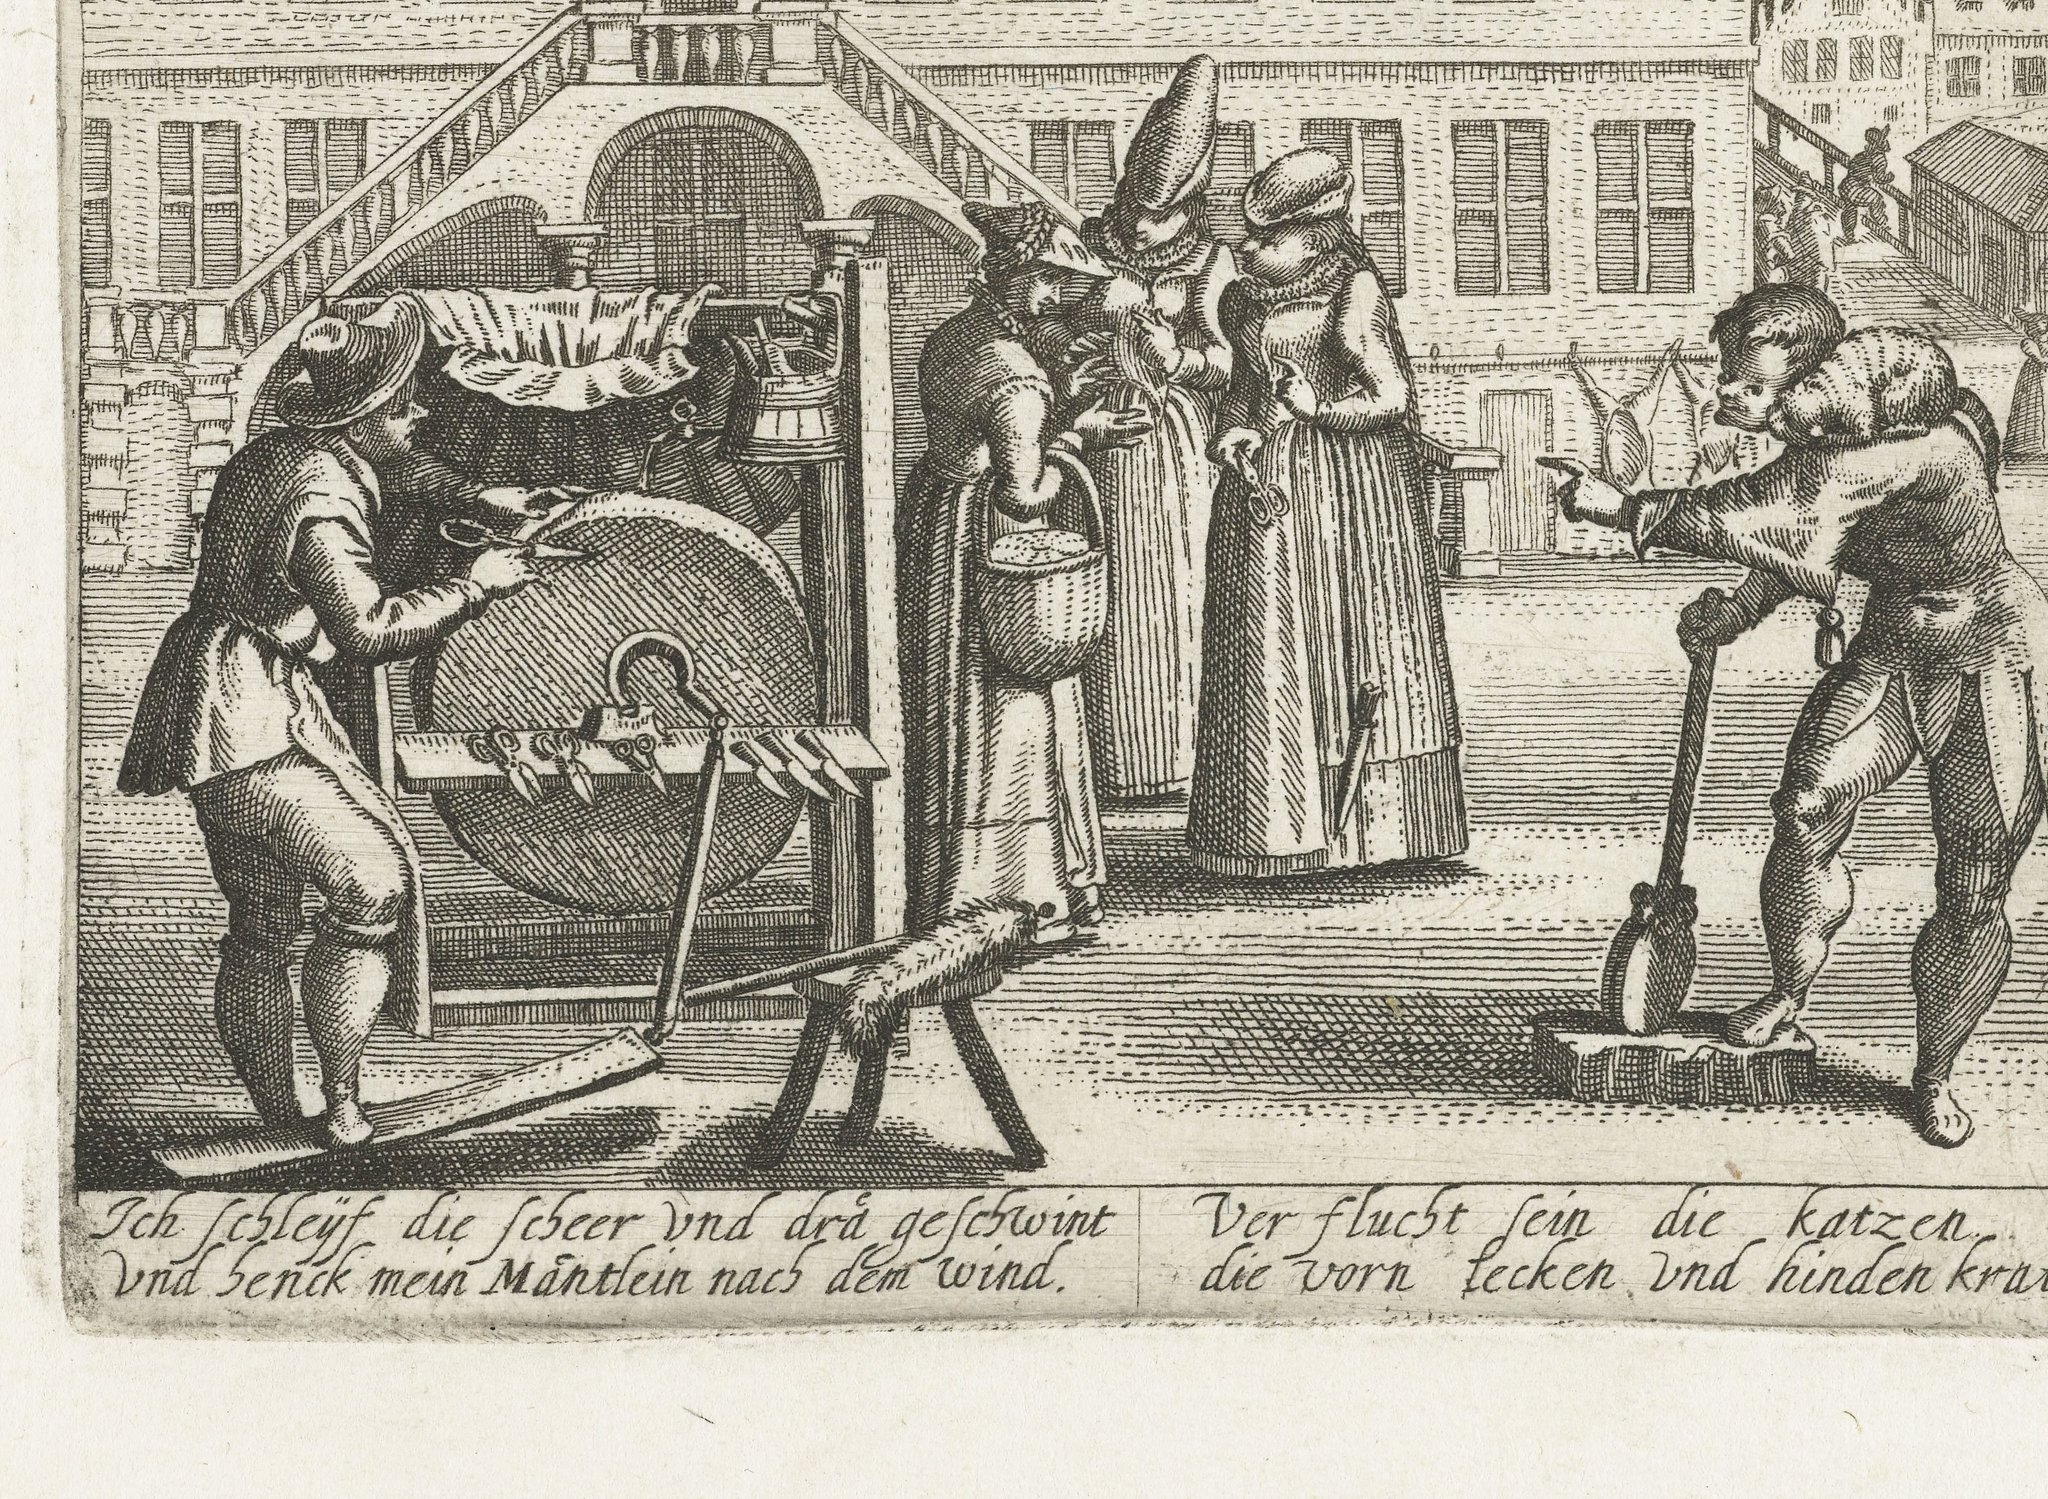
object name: print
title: Pugillus facetiarum iconographicarum in studiosorum (...)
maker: jacob van der heyden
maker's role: draughtsman, print maker, publisher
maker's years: 1573-1645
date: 1608-1618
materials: paper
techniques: etching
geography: straatsburg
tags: sharpening, grinding (industrial processes), 'album amicorum', 'stammbuch', cat, city-view in general; 'veduta', morality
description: Deze serie, getiteld ‘Pugillus facetiarum iconographicarum in studiosorum (…)’, bestond vermoedelijk uit 36 of meer prenten. Van deze serie zijn in ieder geval twee uitgaven bekend, uit 1608 en 1618. De prenten uit deze serie in de collectie van het Rijksmuseum (RP-P-1996-1 t/m RP-P-1996-36) zijn vermoedelijk afkomstig uit verschillende uitgaven, of uit de tweede uitgave. De inhoud van beide uitgaven verschilt, maar om de precieze inhoud van de verschillende uitgaven vast te stellen is meer onderzoek nodig. Er zijn geen volledige exemplaren van de eerste uitgave bekend. Aan de hand van de analyse van een andere serie, ‘Jeucht spieghel’,* die kopieën van ‘Pugillus’ bevat en is uitgegeven in 1610 én de aanwezige exemplaren van prenten uit ‘Pugillus’ in een inmiddels verloren album amicorum uit 1610,** kan in ieder geval van een aantal prenten gesteld worden dat ze al voorkwamen in de uitgave van 1608. Dit geldt voor RP-P-1996-1 (de titelprent), RP-P-1996-5, RP-P-1996-6, RP-P-1996-7, RP-P-1996-8, RP-P-1996-9, RP-P-1996-10, RP-P-1996-11, RP-P-1996-12, RP-P-1996-13, RP-P-1996-14, RP-P-1996-15, RP-P-1996-16, RP-P-1996-17, RP-P-1996-18, RP-P-1996-19, RP-P-1996-24, RP-P-1996-28, RP-P-1996-29, RP-P-1996-33 en RP-P-1996-35. Van één prent (RP-P-1996-31) kan vastgesteld worden dat die pas in de latere uitgave van 1618 voorkwam, omdat het kopie is van een prent uit weer een andere serie, ‘Academia sive speculum vitae scholasticae (…)’, die werd uitgegeven in 1612.*** Van de huidige prent is onduidelijk of hij al voorkwam in de uitgave van 1608. * Z.G.H.P.H.S [Zacharias Heyns]. Jeucht spieghel. S.l.s.n., 1610. Voor een gedigitaliseerd exemplaar zie: https://archive.org/details/ned-kbn-all-00000628-001/page/n9/mode/2up. ** Zie: Erman, Wilhelm en Ewald Horn. Bibliographie der deutschen Universitäten, systematisch geordnetes Verzeichnis der bis Ende 1899 gedruckten Bücher und Aufsätze über das deutsche Universitätswesen. Leipzig en Berlijn: Verlag von B.G. Teubner, 1904, dl. 1, p. 826-832, no. 17328. https://archive.org/details/bibliographieder01ermauoft/page/826/mode/2up *** Passe, Crispijn van de (I). Academia sive speculum vitae scholasticae (…). Arnhem: Johannes Janssonius [Jan Jansz.], 1612. Voor een gedigitaliseerd exemplaar zie: http://gallica.bnf.fr/ark:/12148/btv1b55005974h.